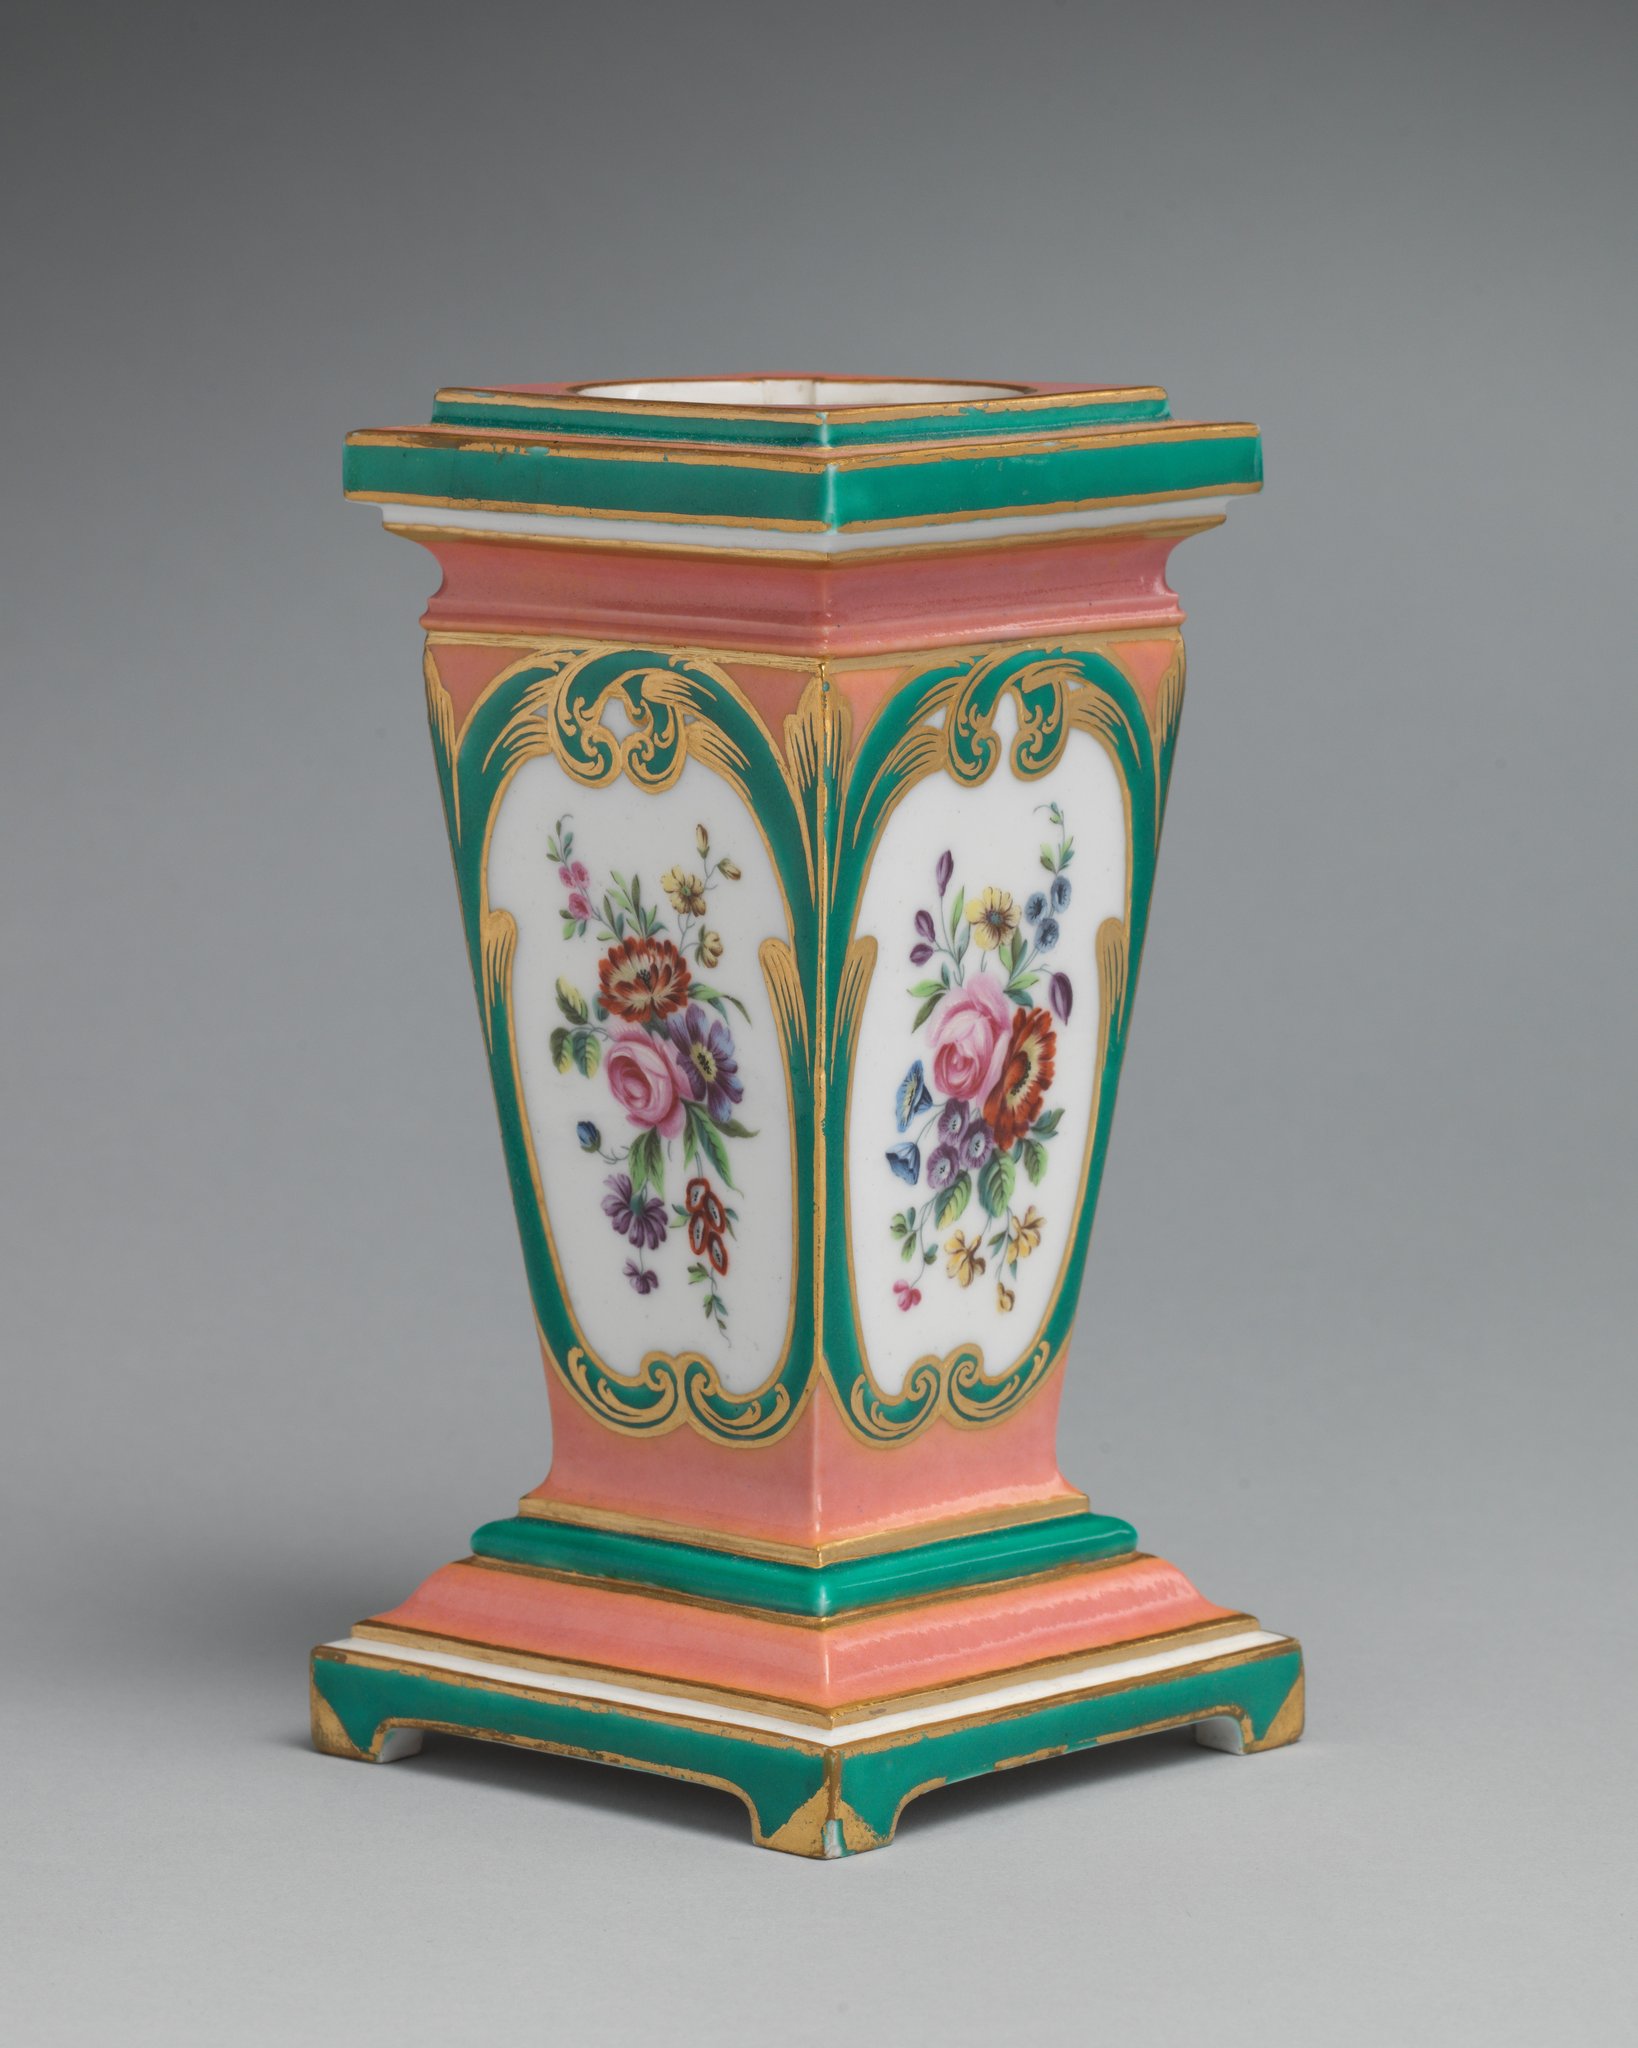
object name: pedestal vase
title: Pedestal vase and bulb pot (piédestal en gaine) (one of a pair)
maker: sèvres manufactory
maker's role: manufactory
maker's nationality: french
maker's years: 1740-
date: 1760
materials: soft paste porcelain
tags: flowers